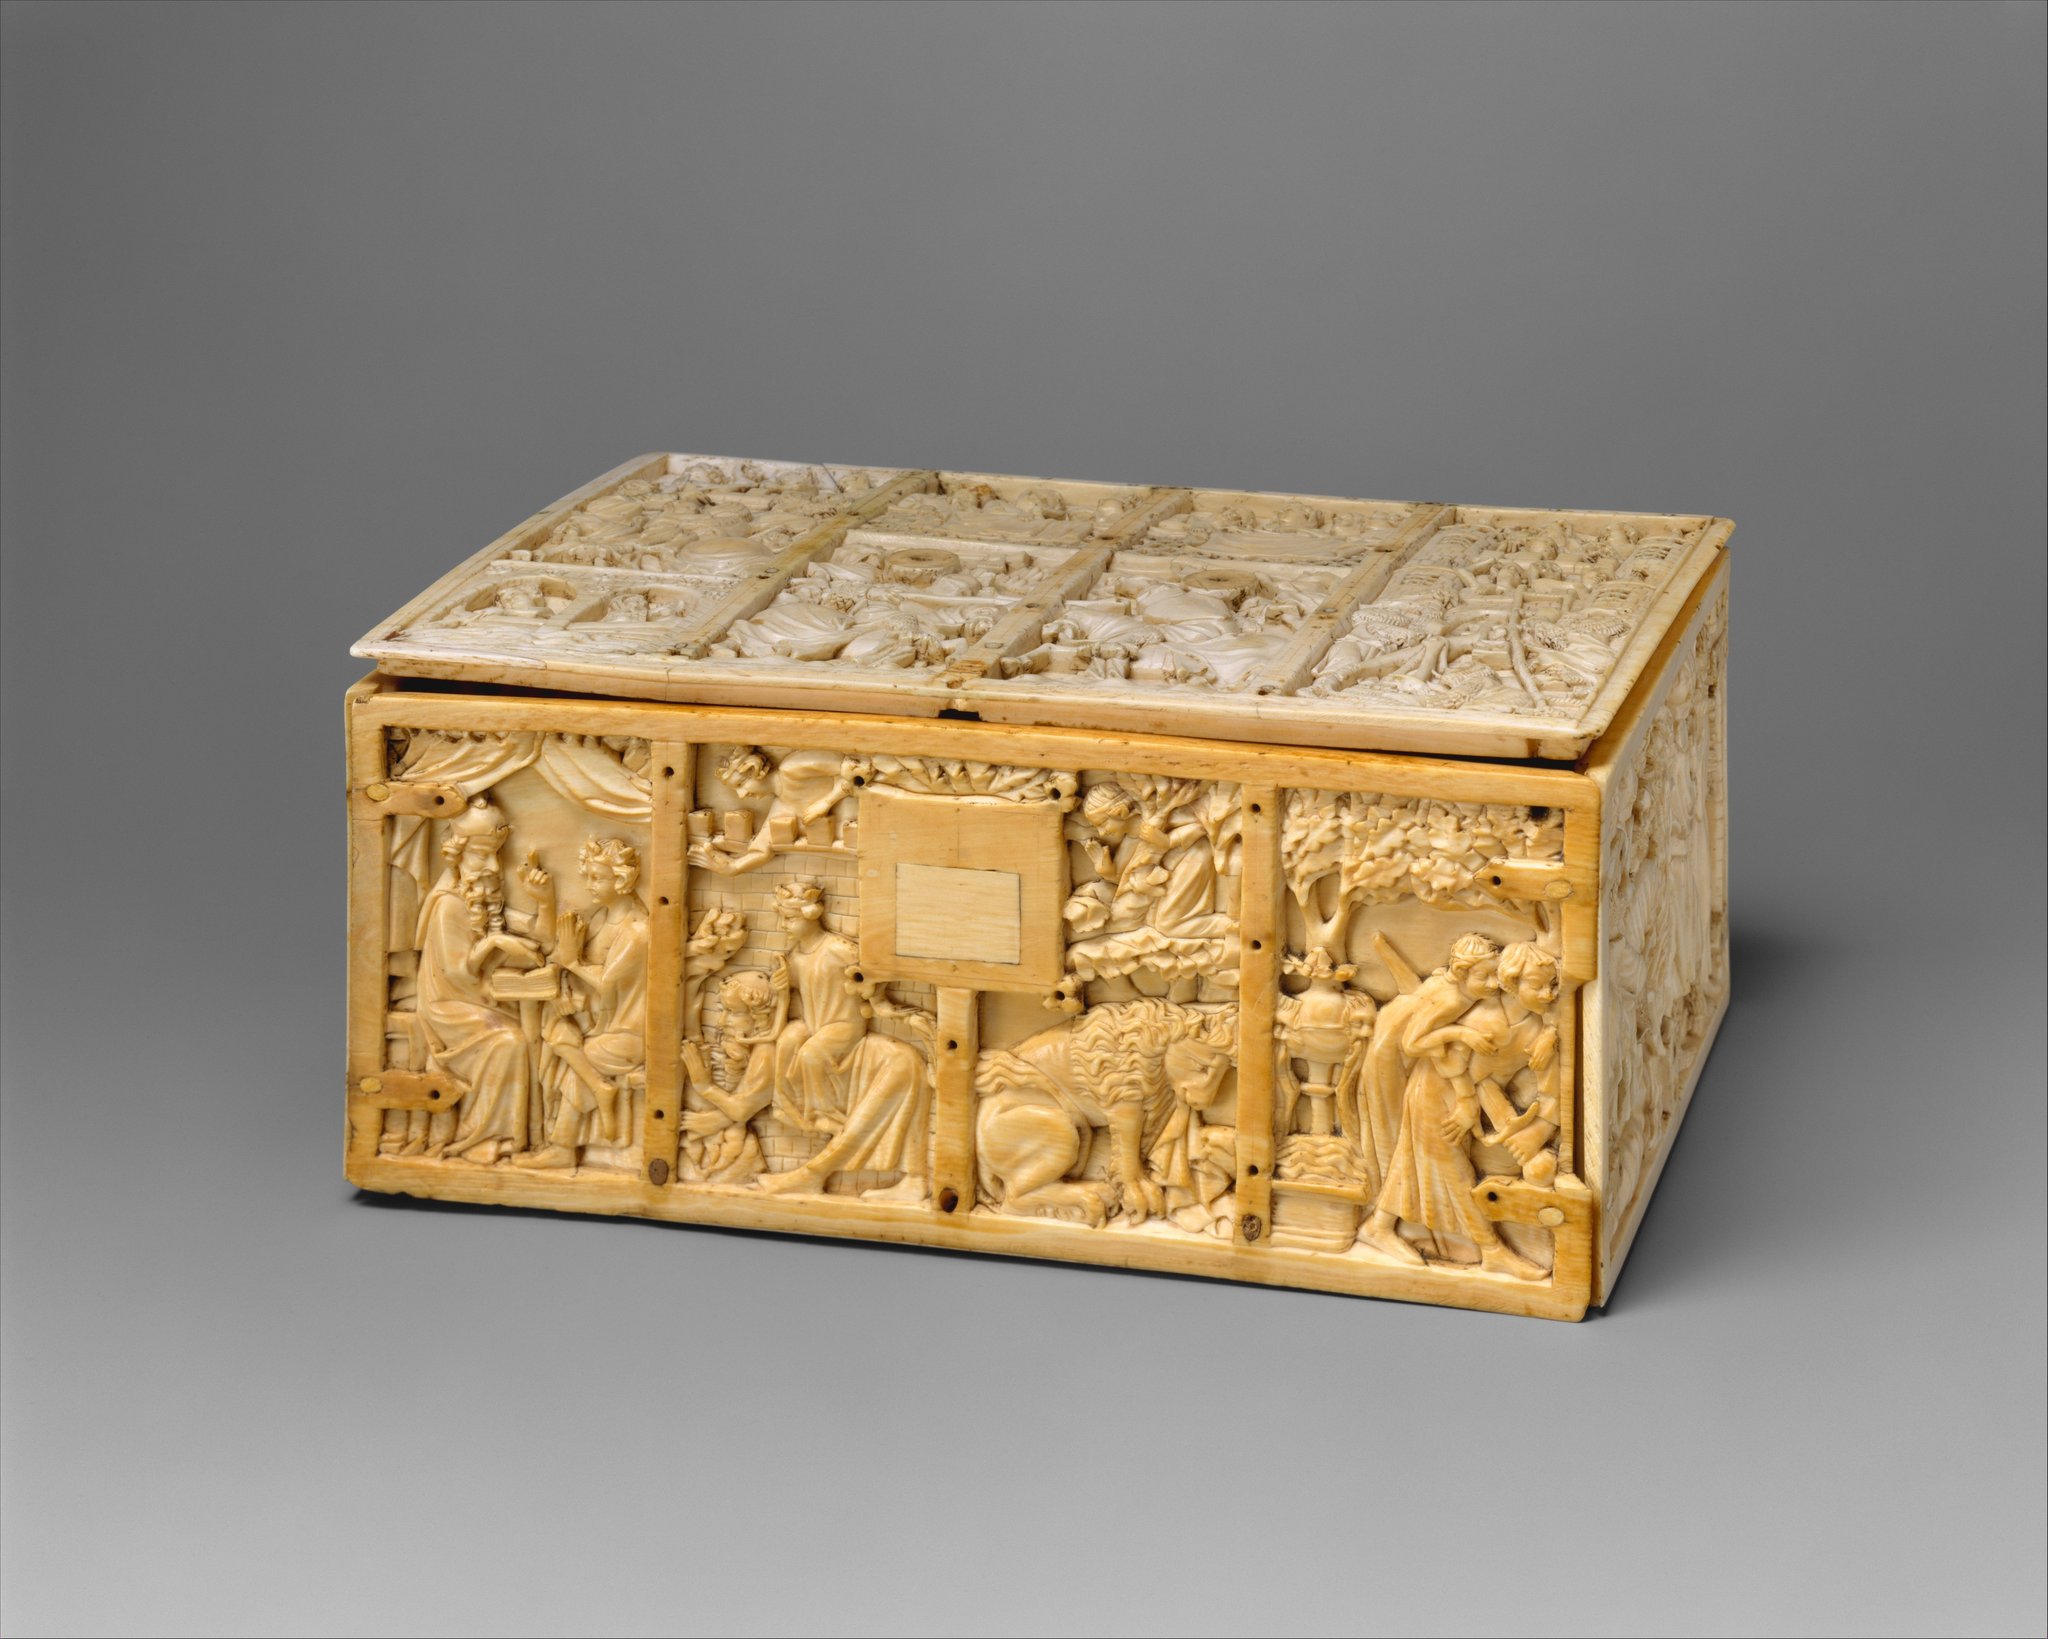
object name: box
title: Box with Romance Scenes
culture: french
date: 1310-1330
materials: ivory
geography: france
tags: alexander the great,aristotle,women,unicorns,dogs,horses,lions,knights